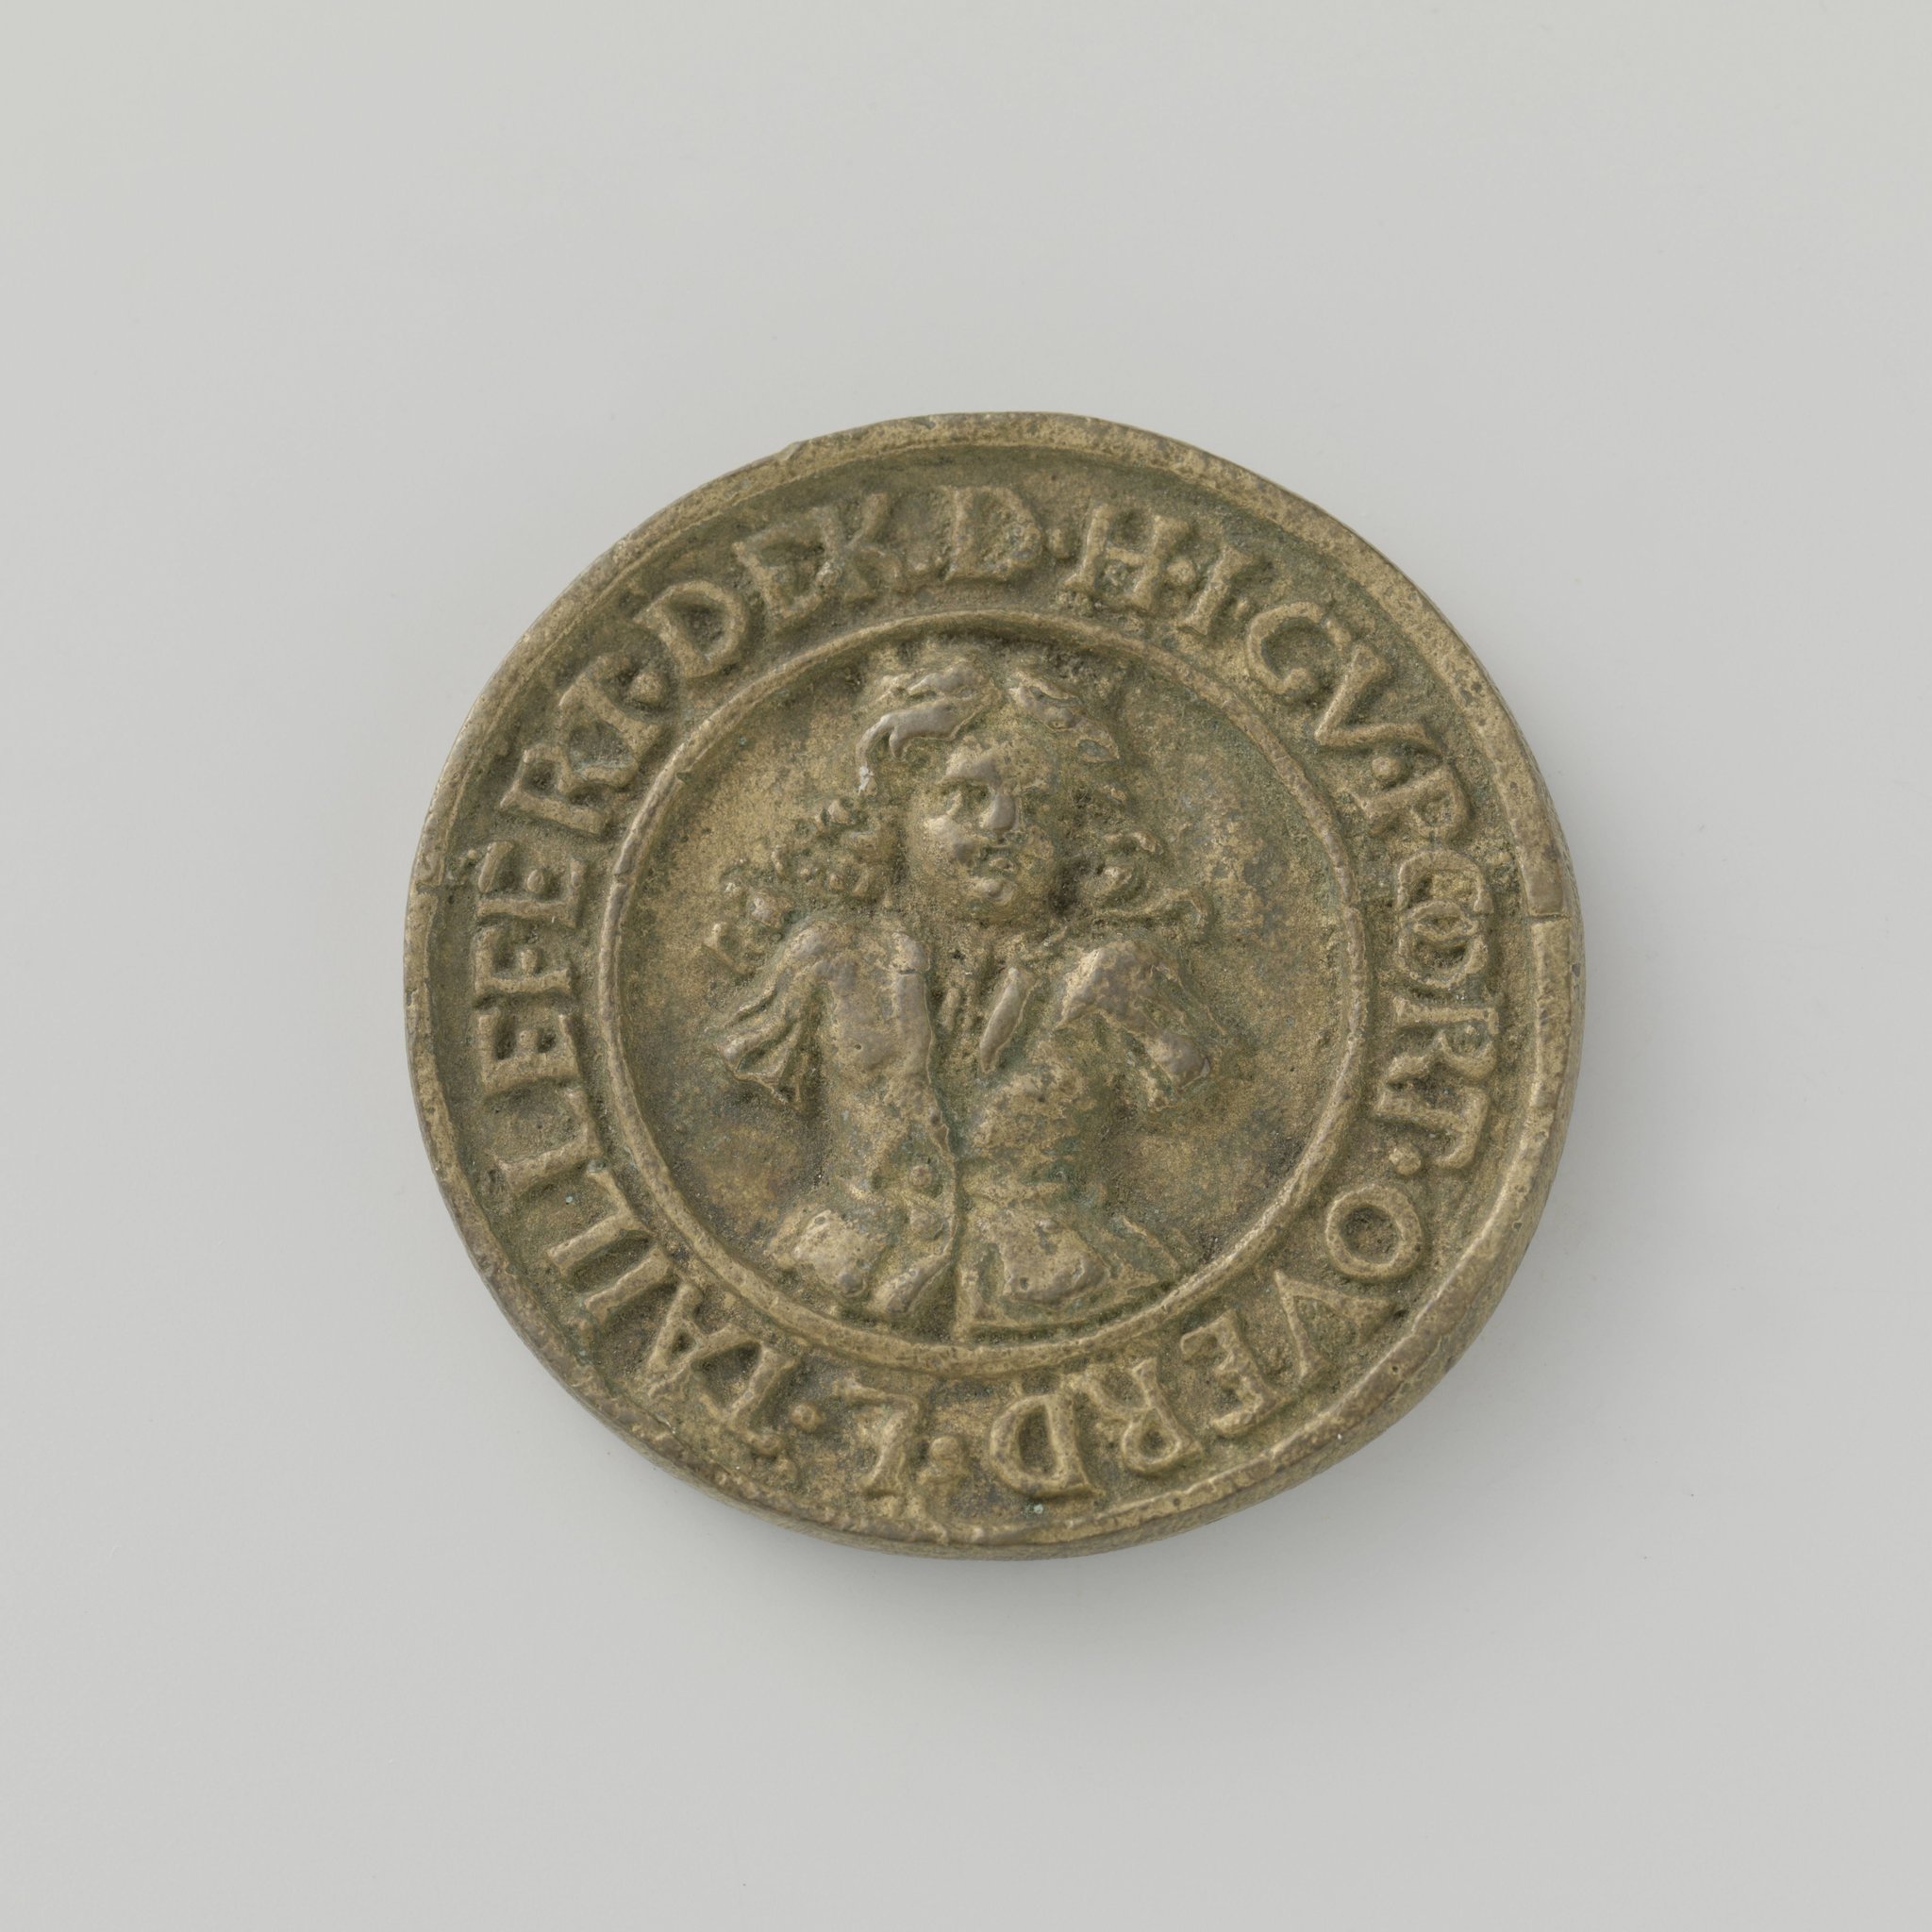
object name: medal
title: Furriers and Wigmakers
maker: Anonymous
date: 1718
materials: brass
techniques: casting, engraving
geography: middelburg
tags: middelburg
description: Guild medals Members of trade guilds had to identify themselves with a medal at their meetings.